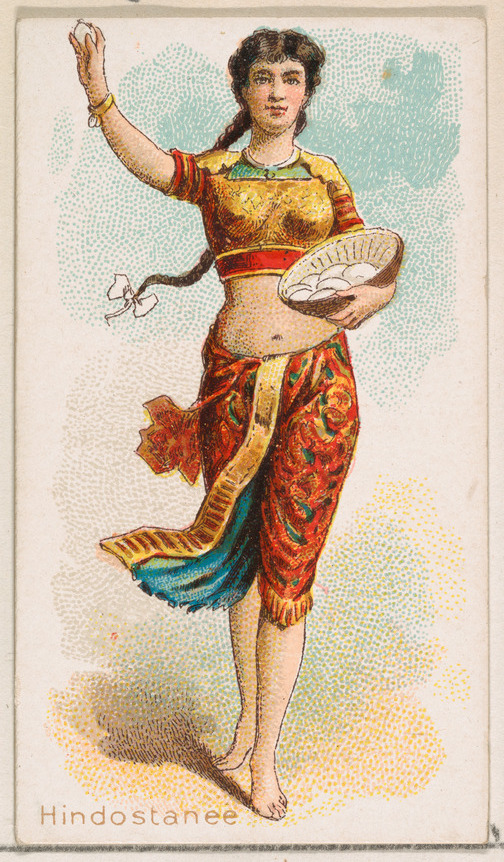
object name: print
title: Hindostanee Dancer, from the Dancing Women series (N186) issued by Wm. S. Kimball & Co.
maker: william s. kimball & company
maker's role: publisher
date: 1889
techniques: color lithograph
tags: women,dancing,dancers